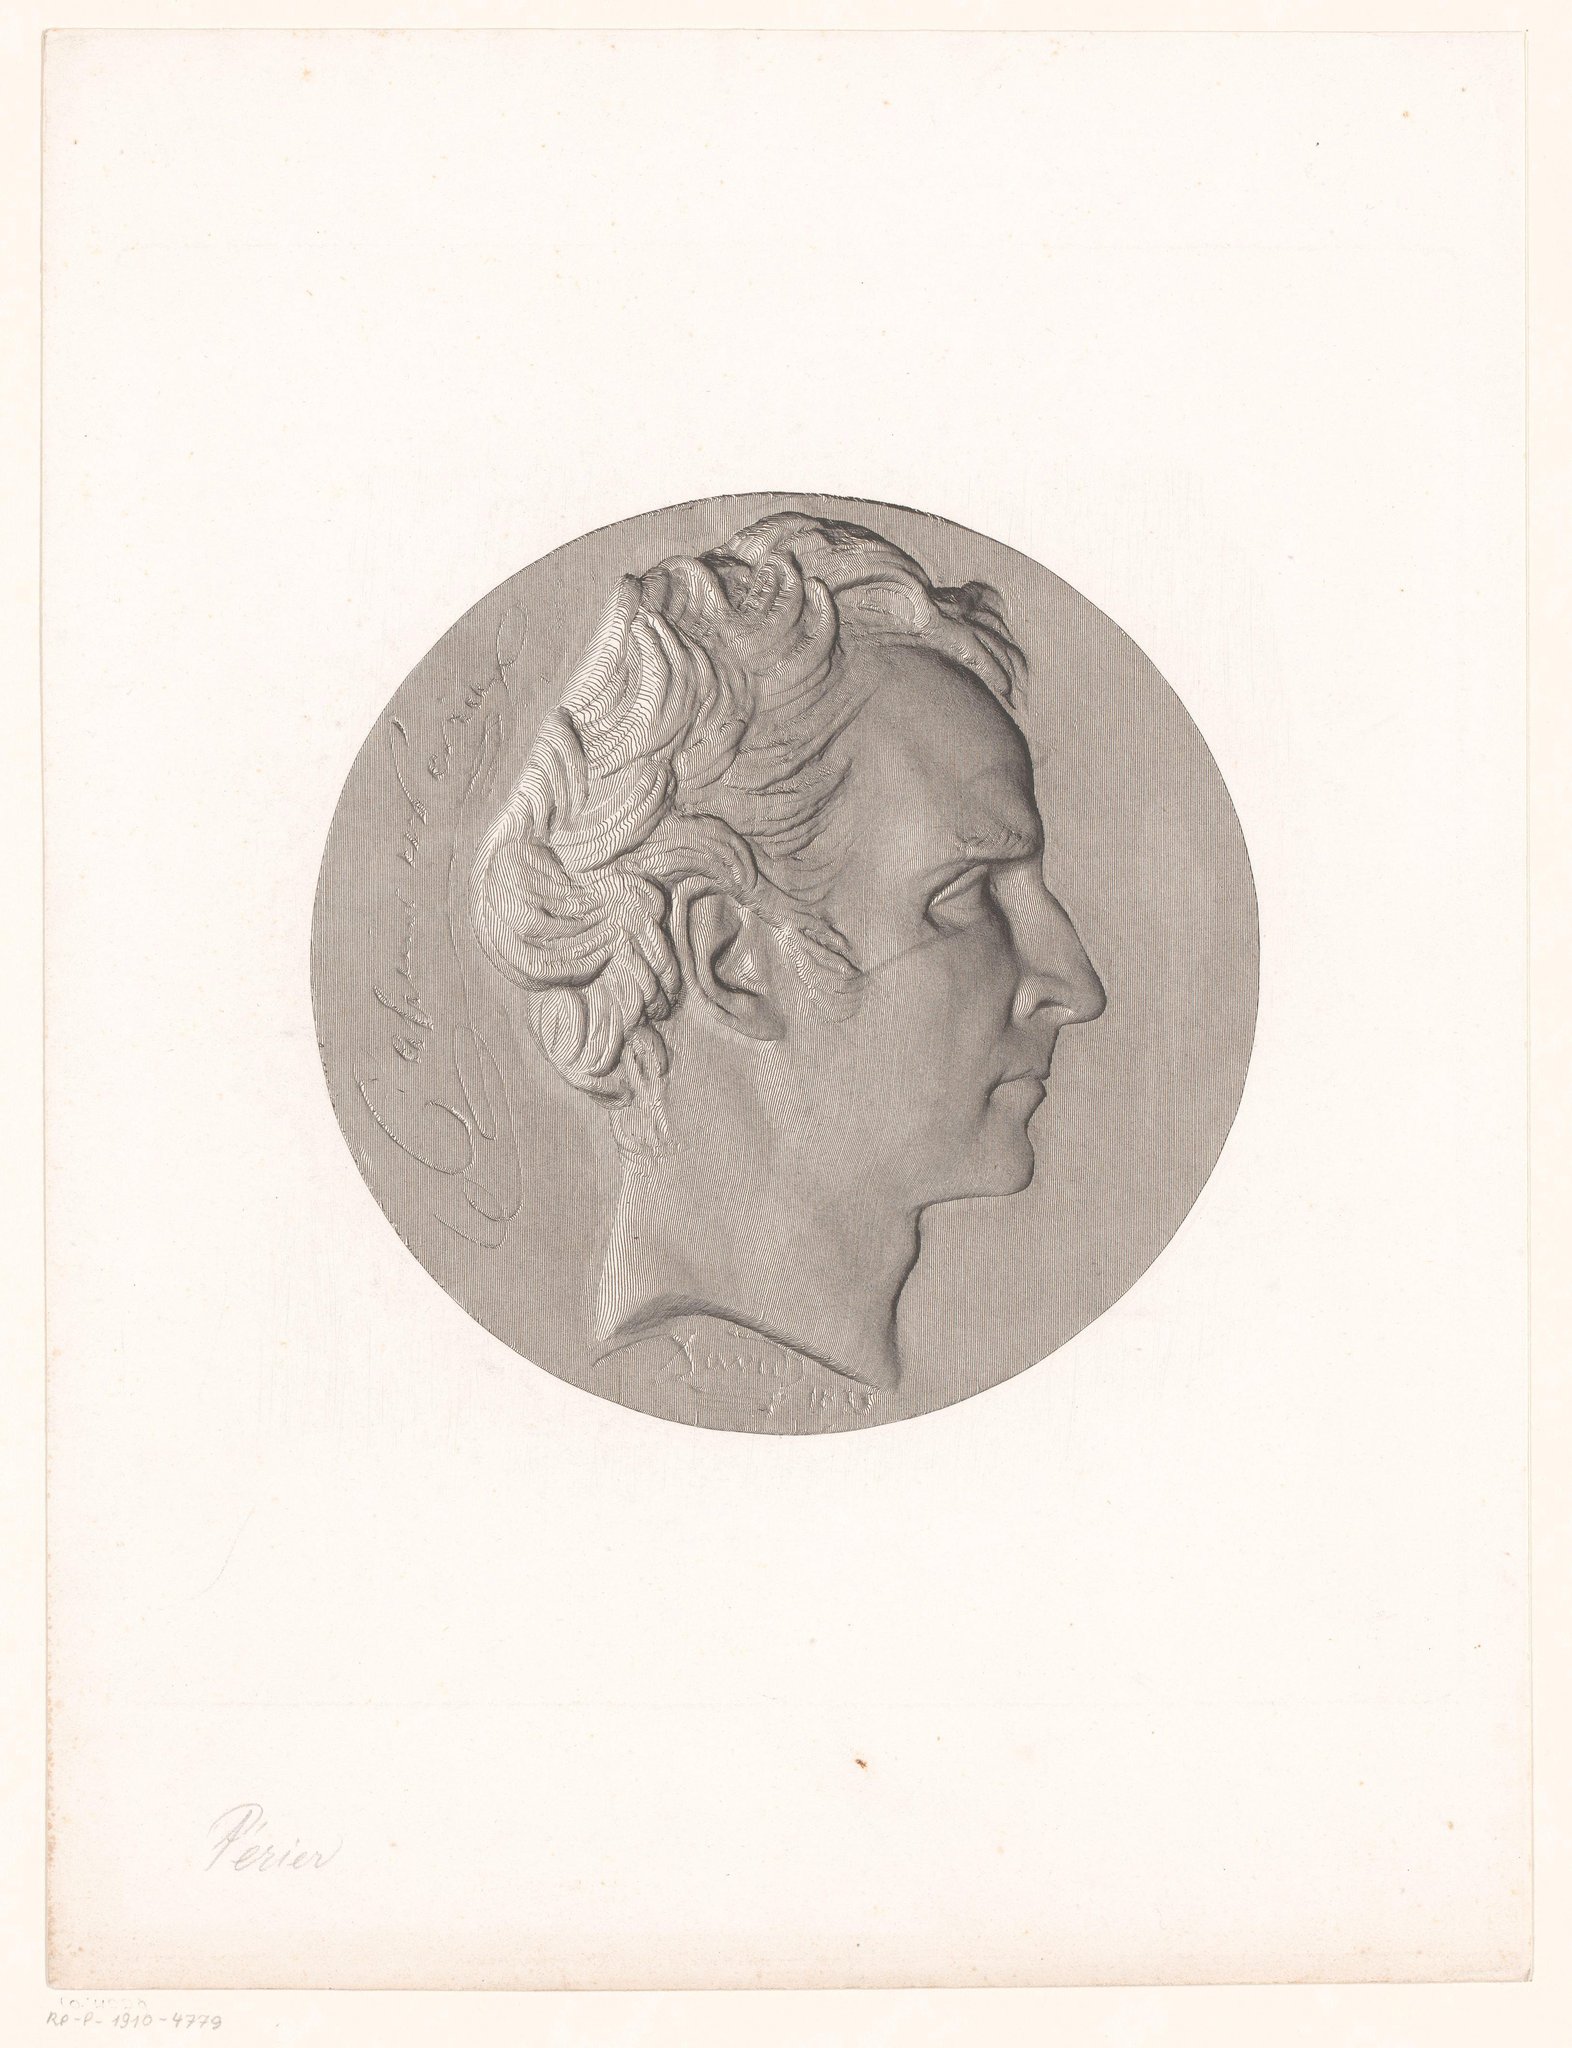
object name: print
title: Casimir Périer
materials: paper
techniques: relief engraving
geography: france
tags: paris, politician, ornament ~ medallion, historical persons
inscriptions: collector's mark: Lugt 2228